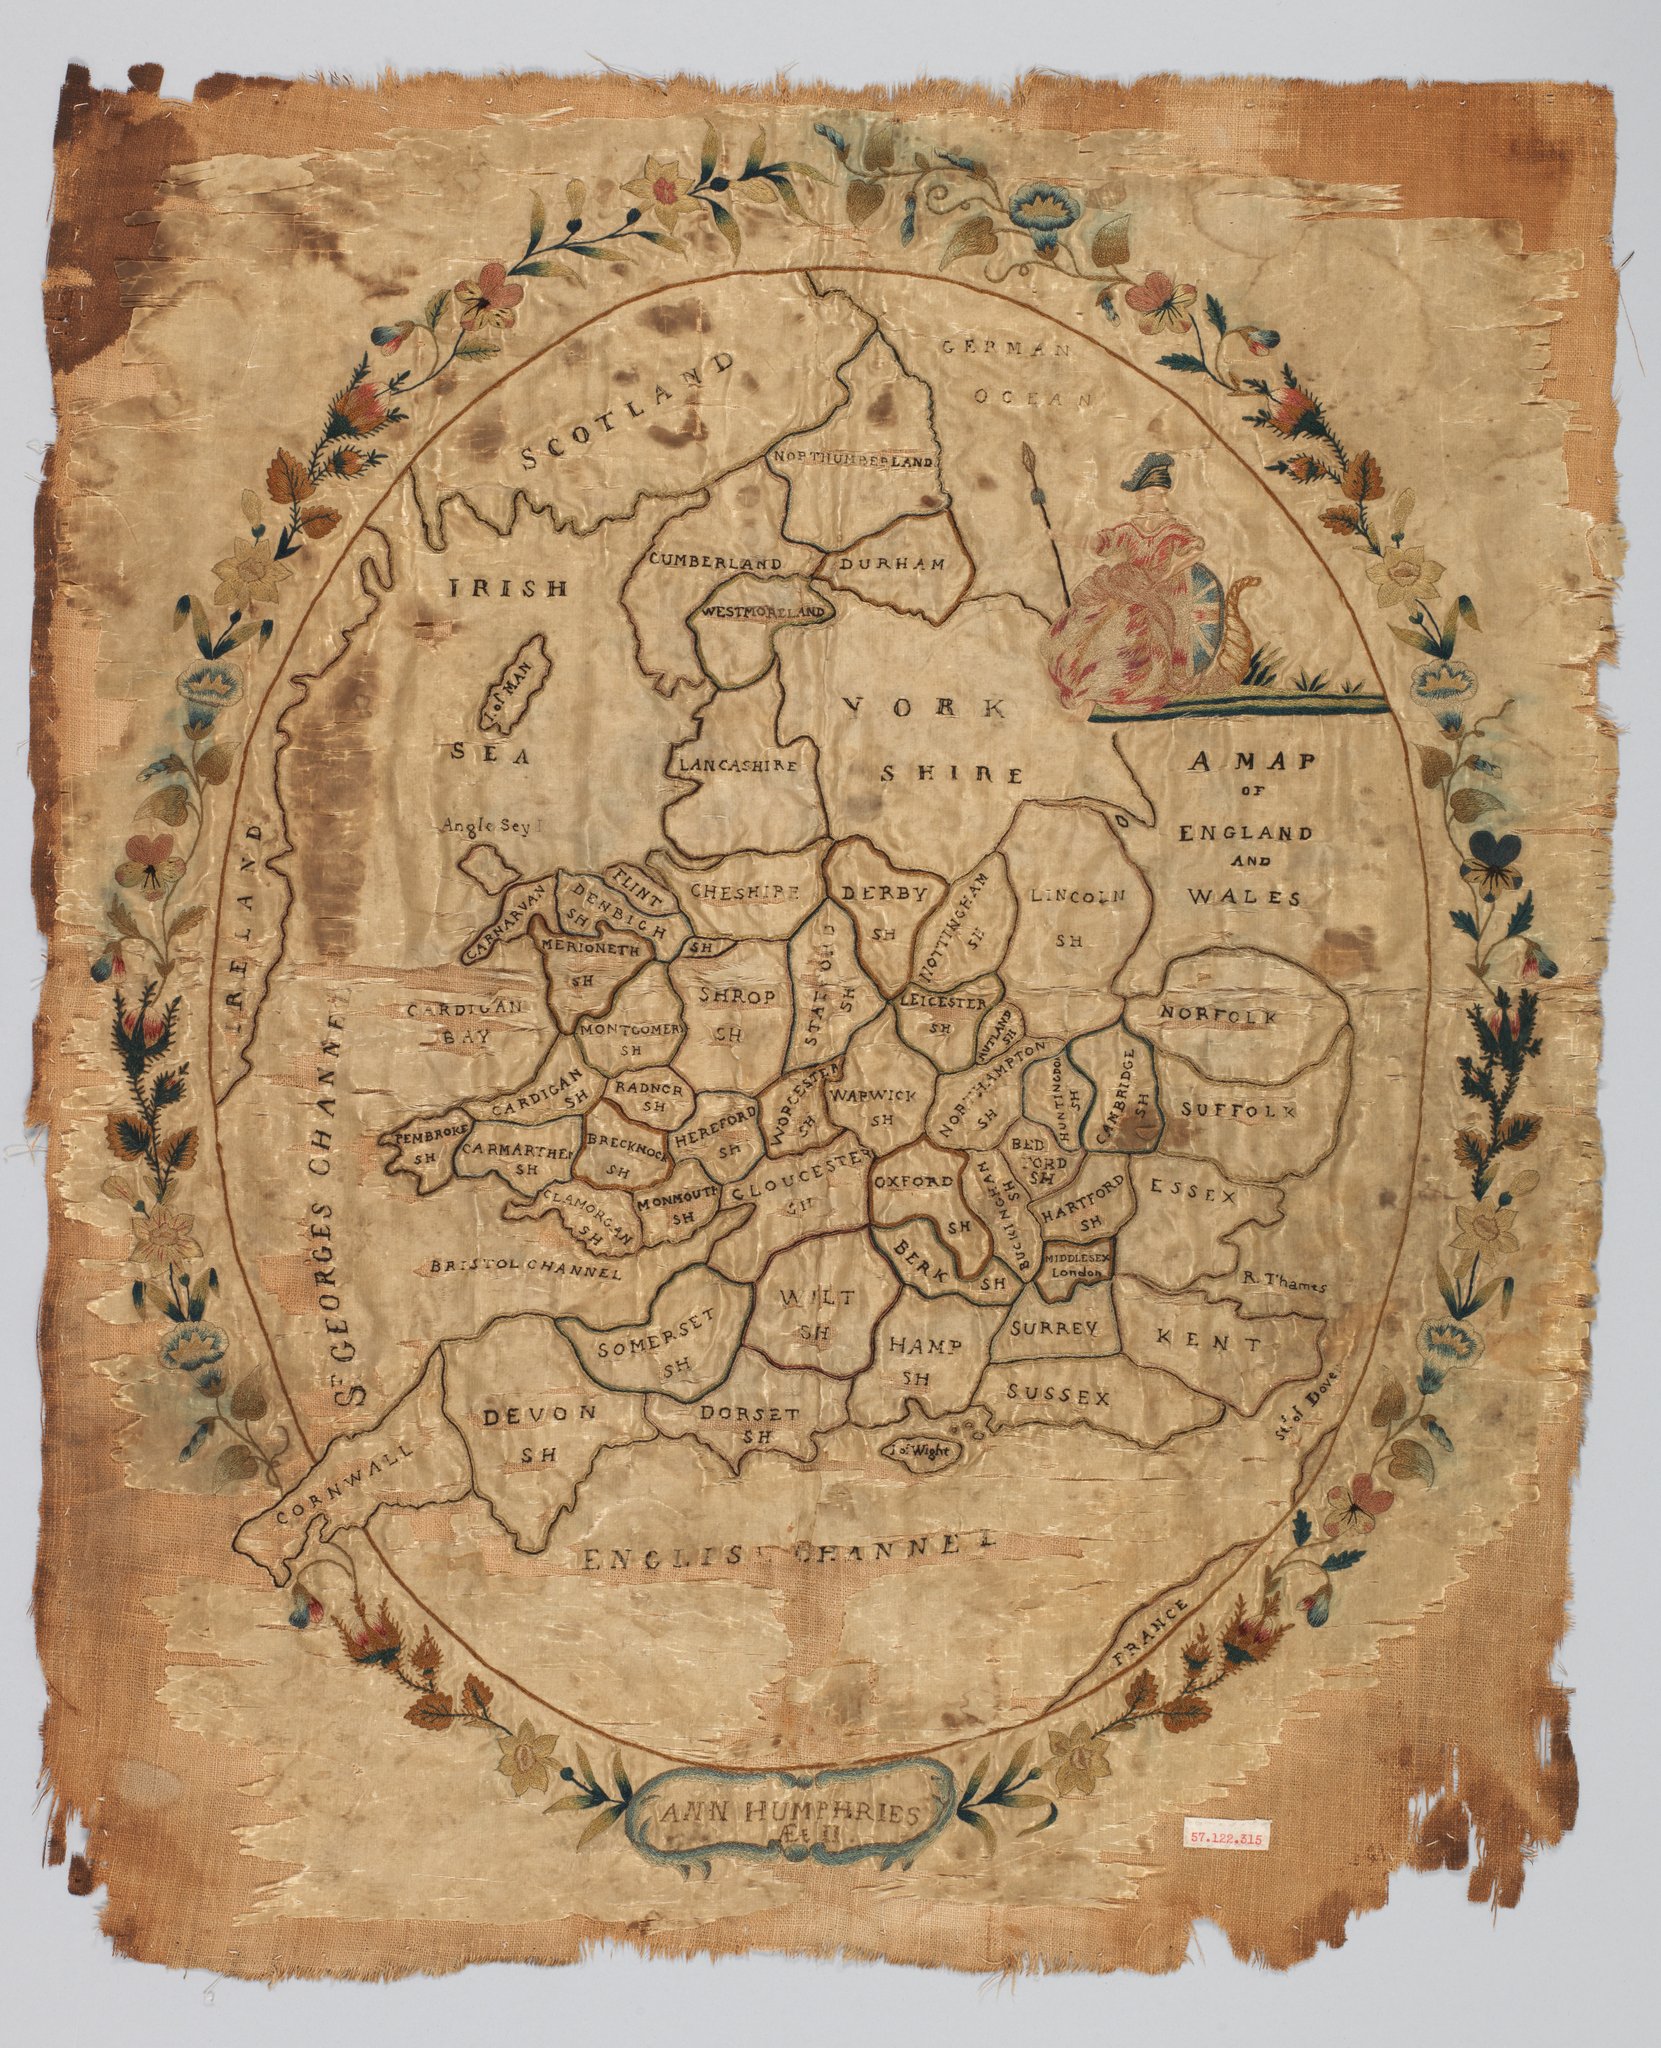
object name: sampler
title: Embroidered map sampler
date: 1767-1833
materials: silk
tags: women,flowers,maps